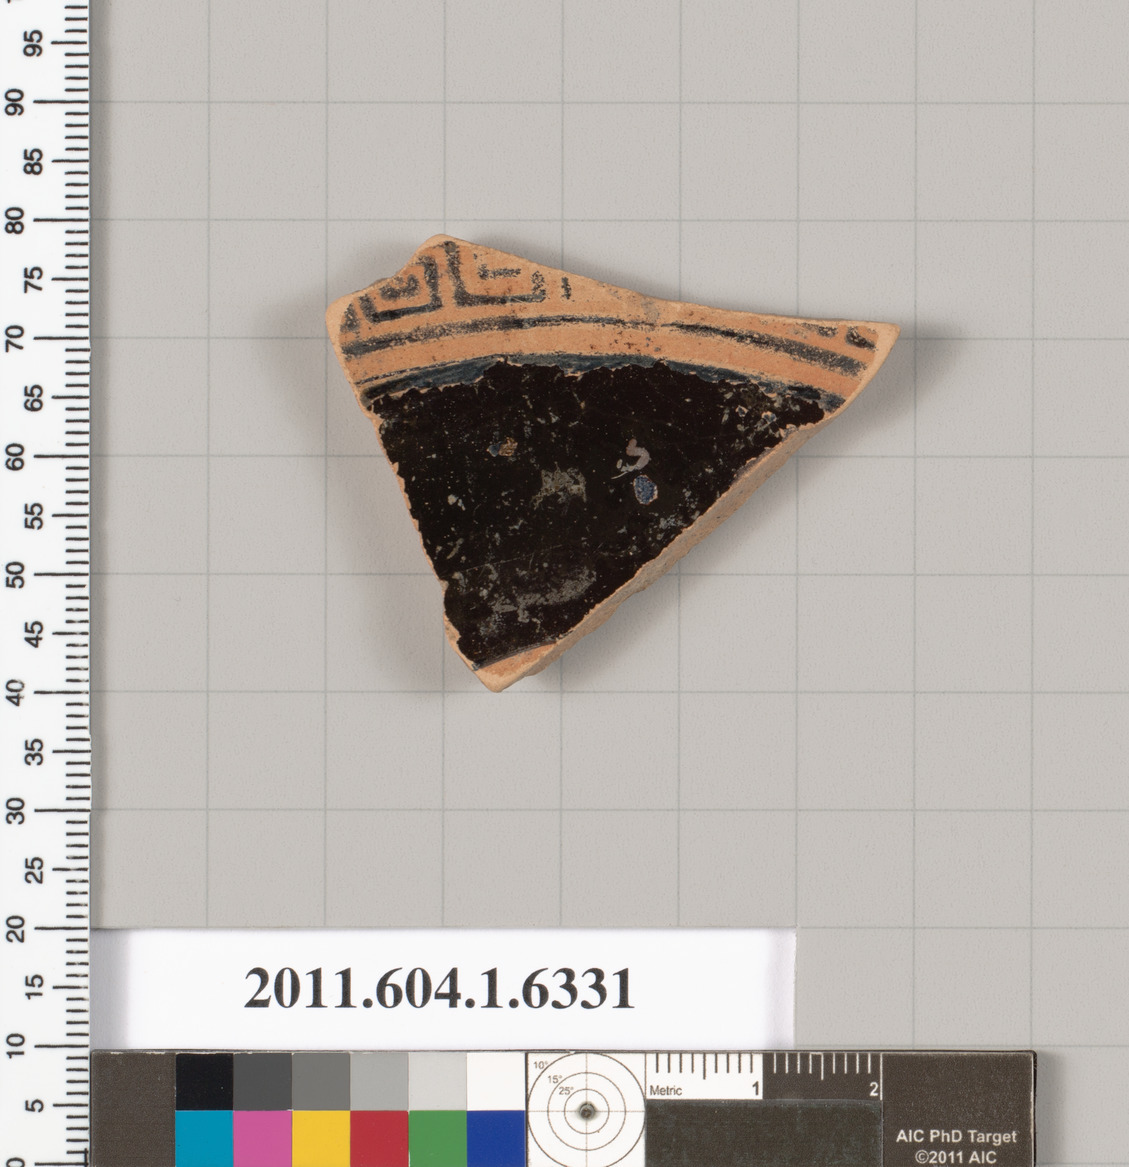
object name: kylix fragment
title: Terracotta fragment of a kylix (drinking cup)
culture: greek, attic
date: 500-480 BCE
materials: terracotta